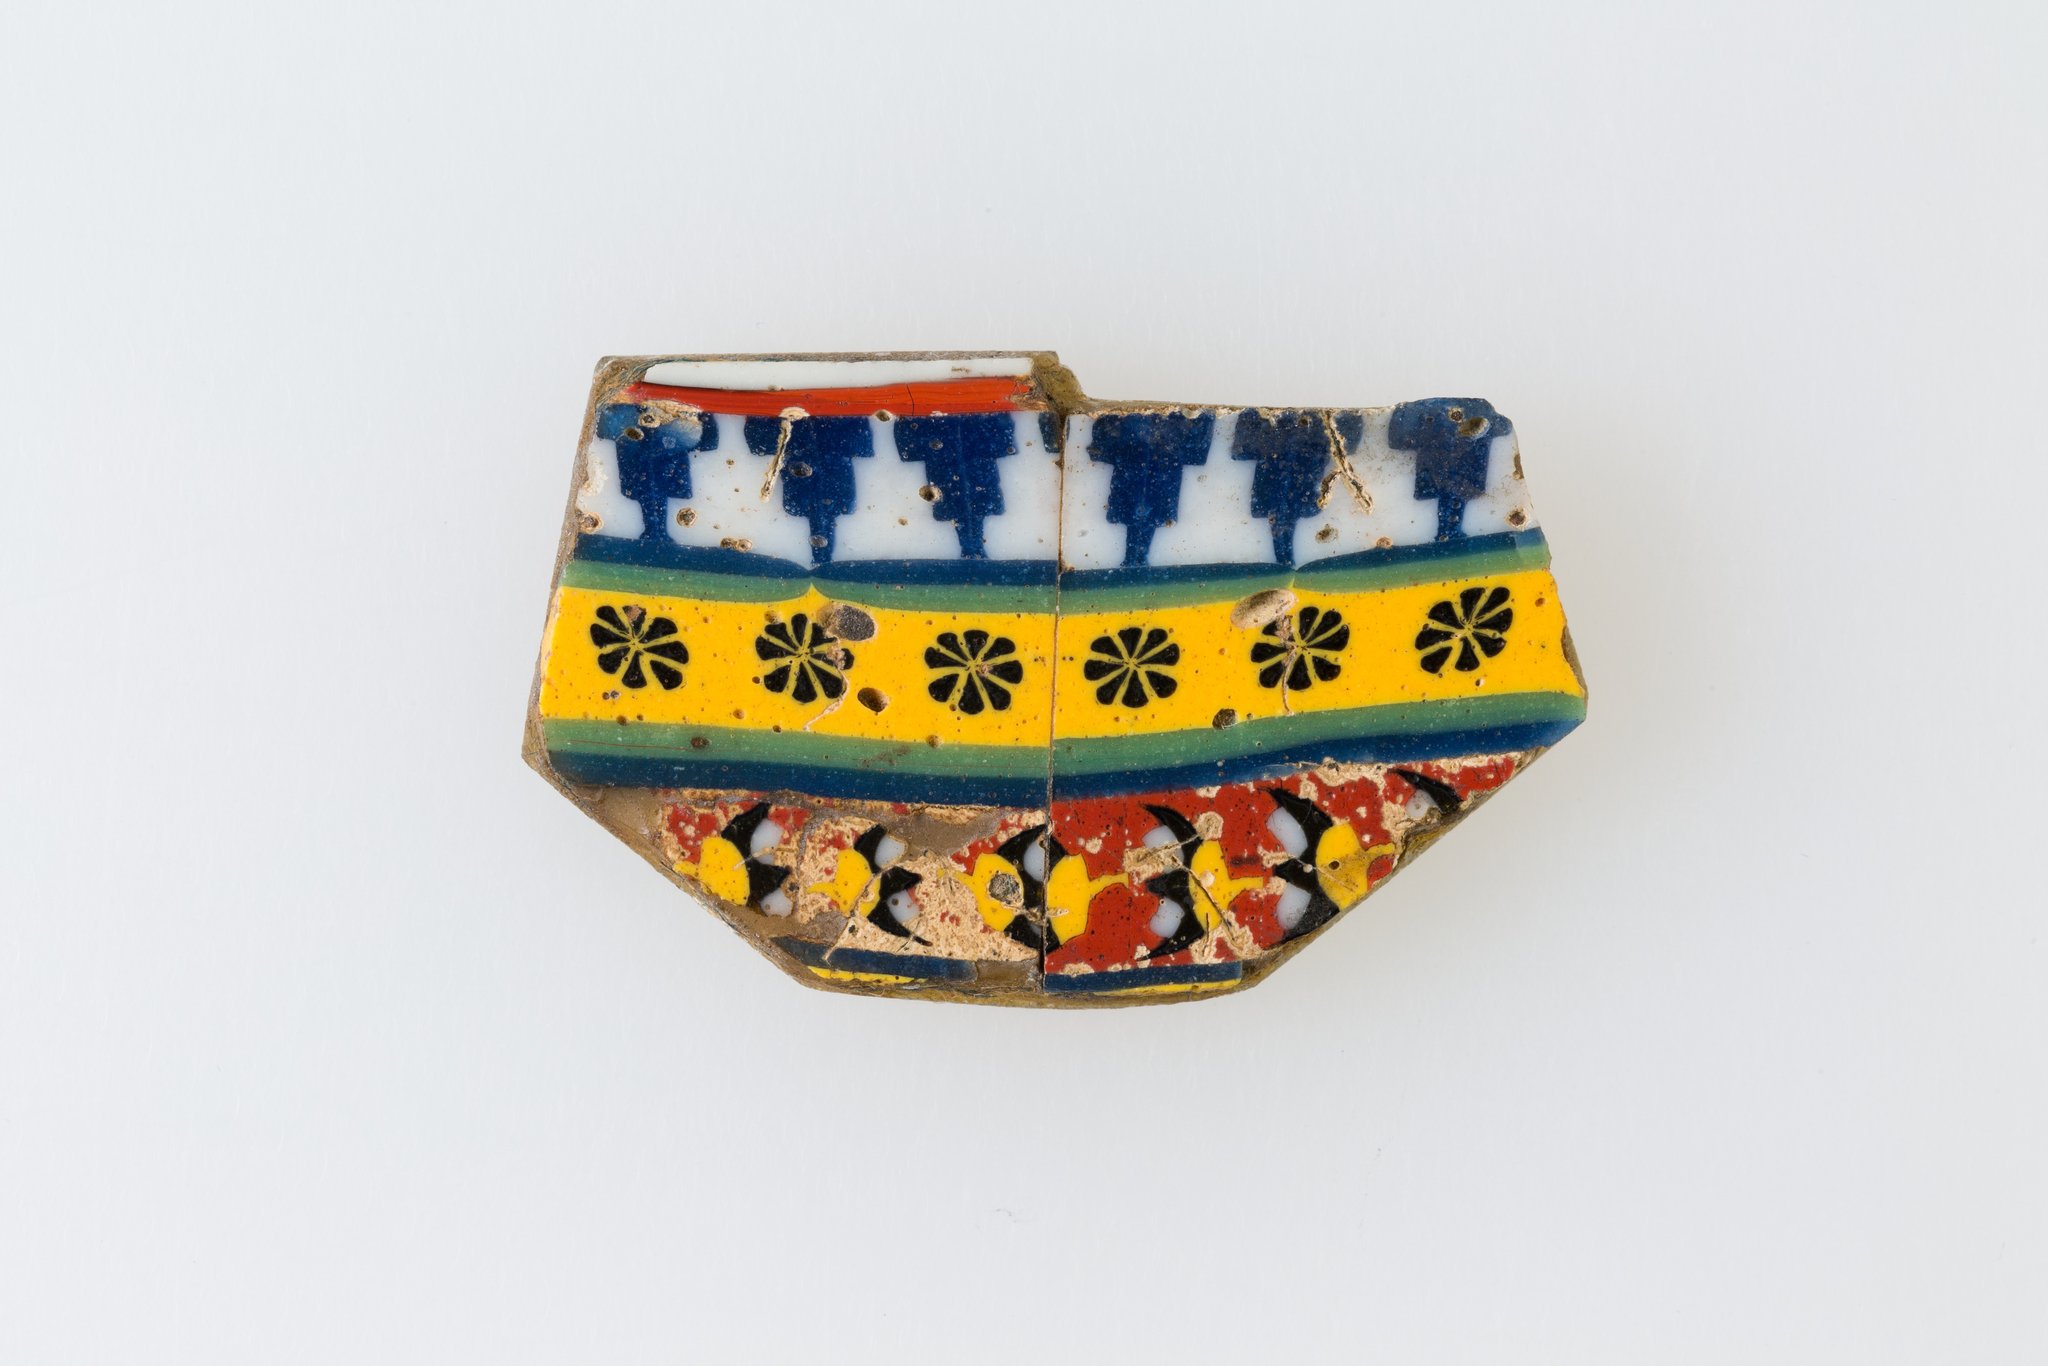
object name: inlay, border pattern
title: Inlay, row of stepped forms, row of rosettes, unclear pattern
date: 100 BCE-100 CE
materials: glass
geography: egypt